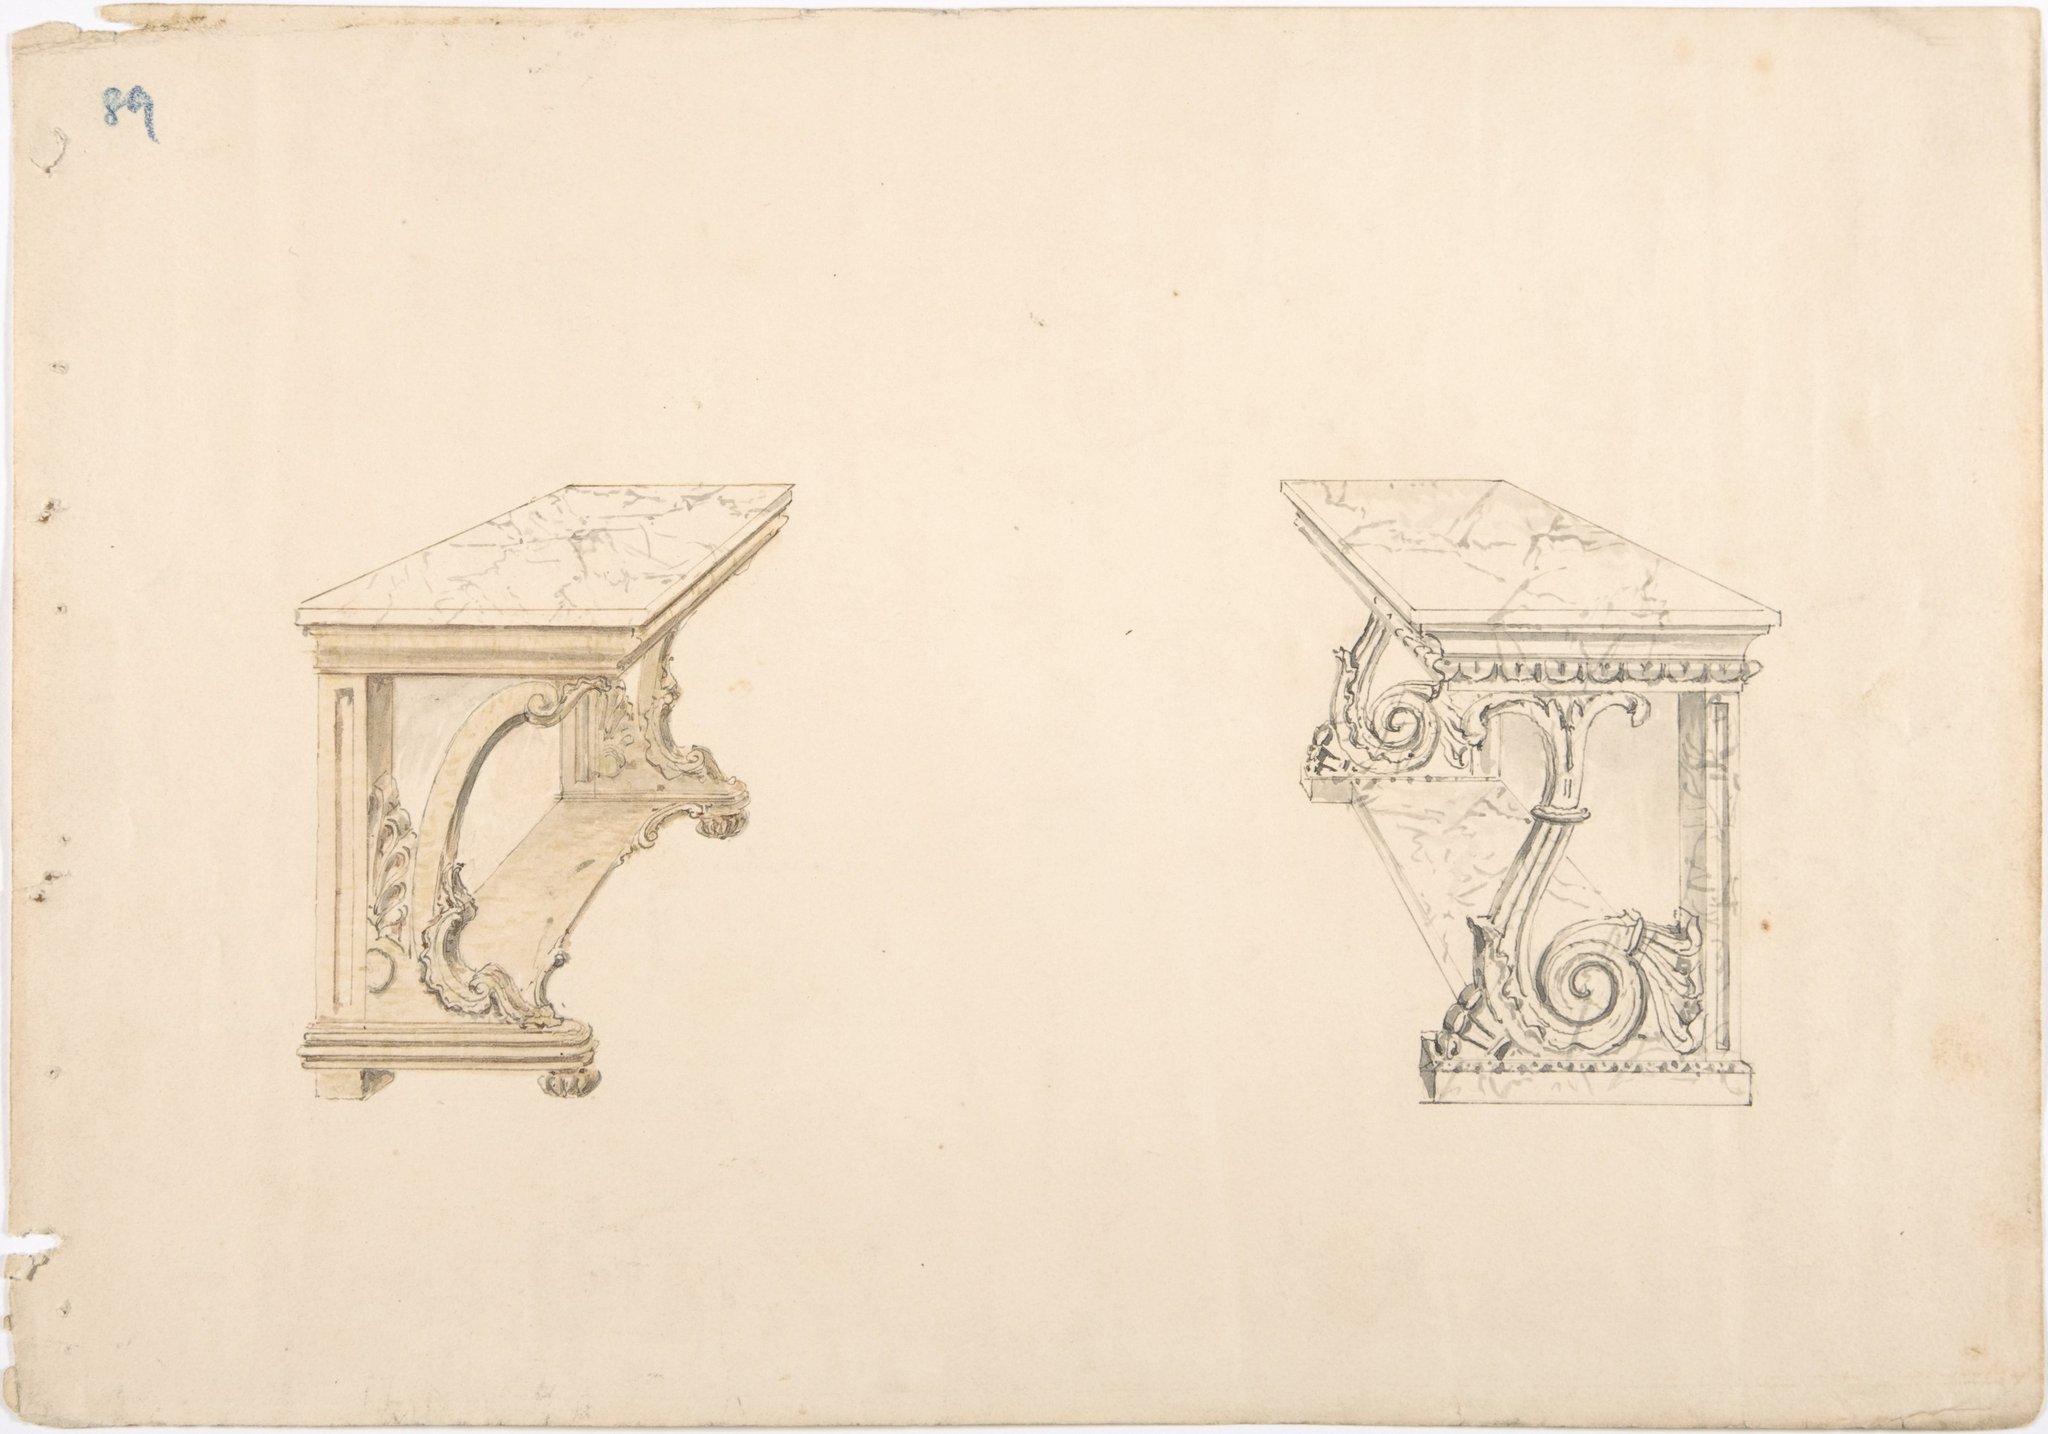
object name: drawing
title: Design for Two Marble-topped Pier Tables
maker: anonymous, british, 19th century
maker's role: artist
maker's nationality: british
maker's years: 1800-1900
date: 1801-1833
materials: graphite, ink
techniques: brush, pen, wash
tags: tables